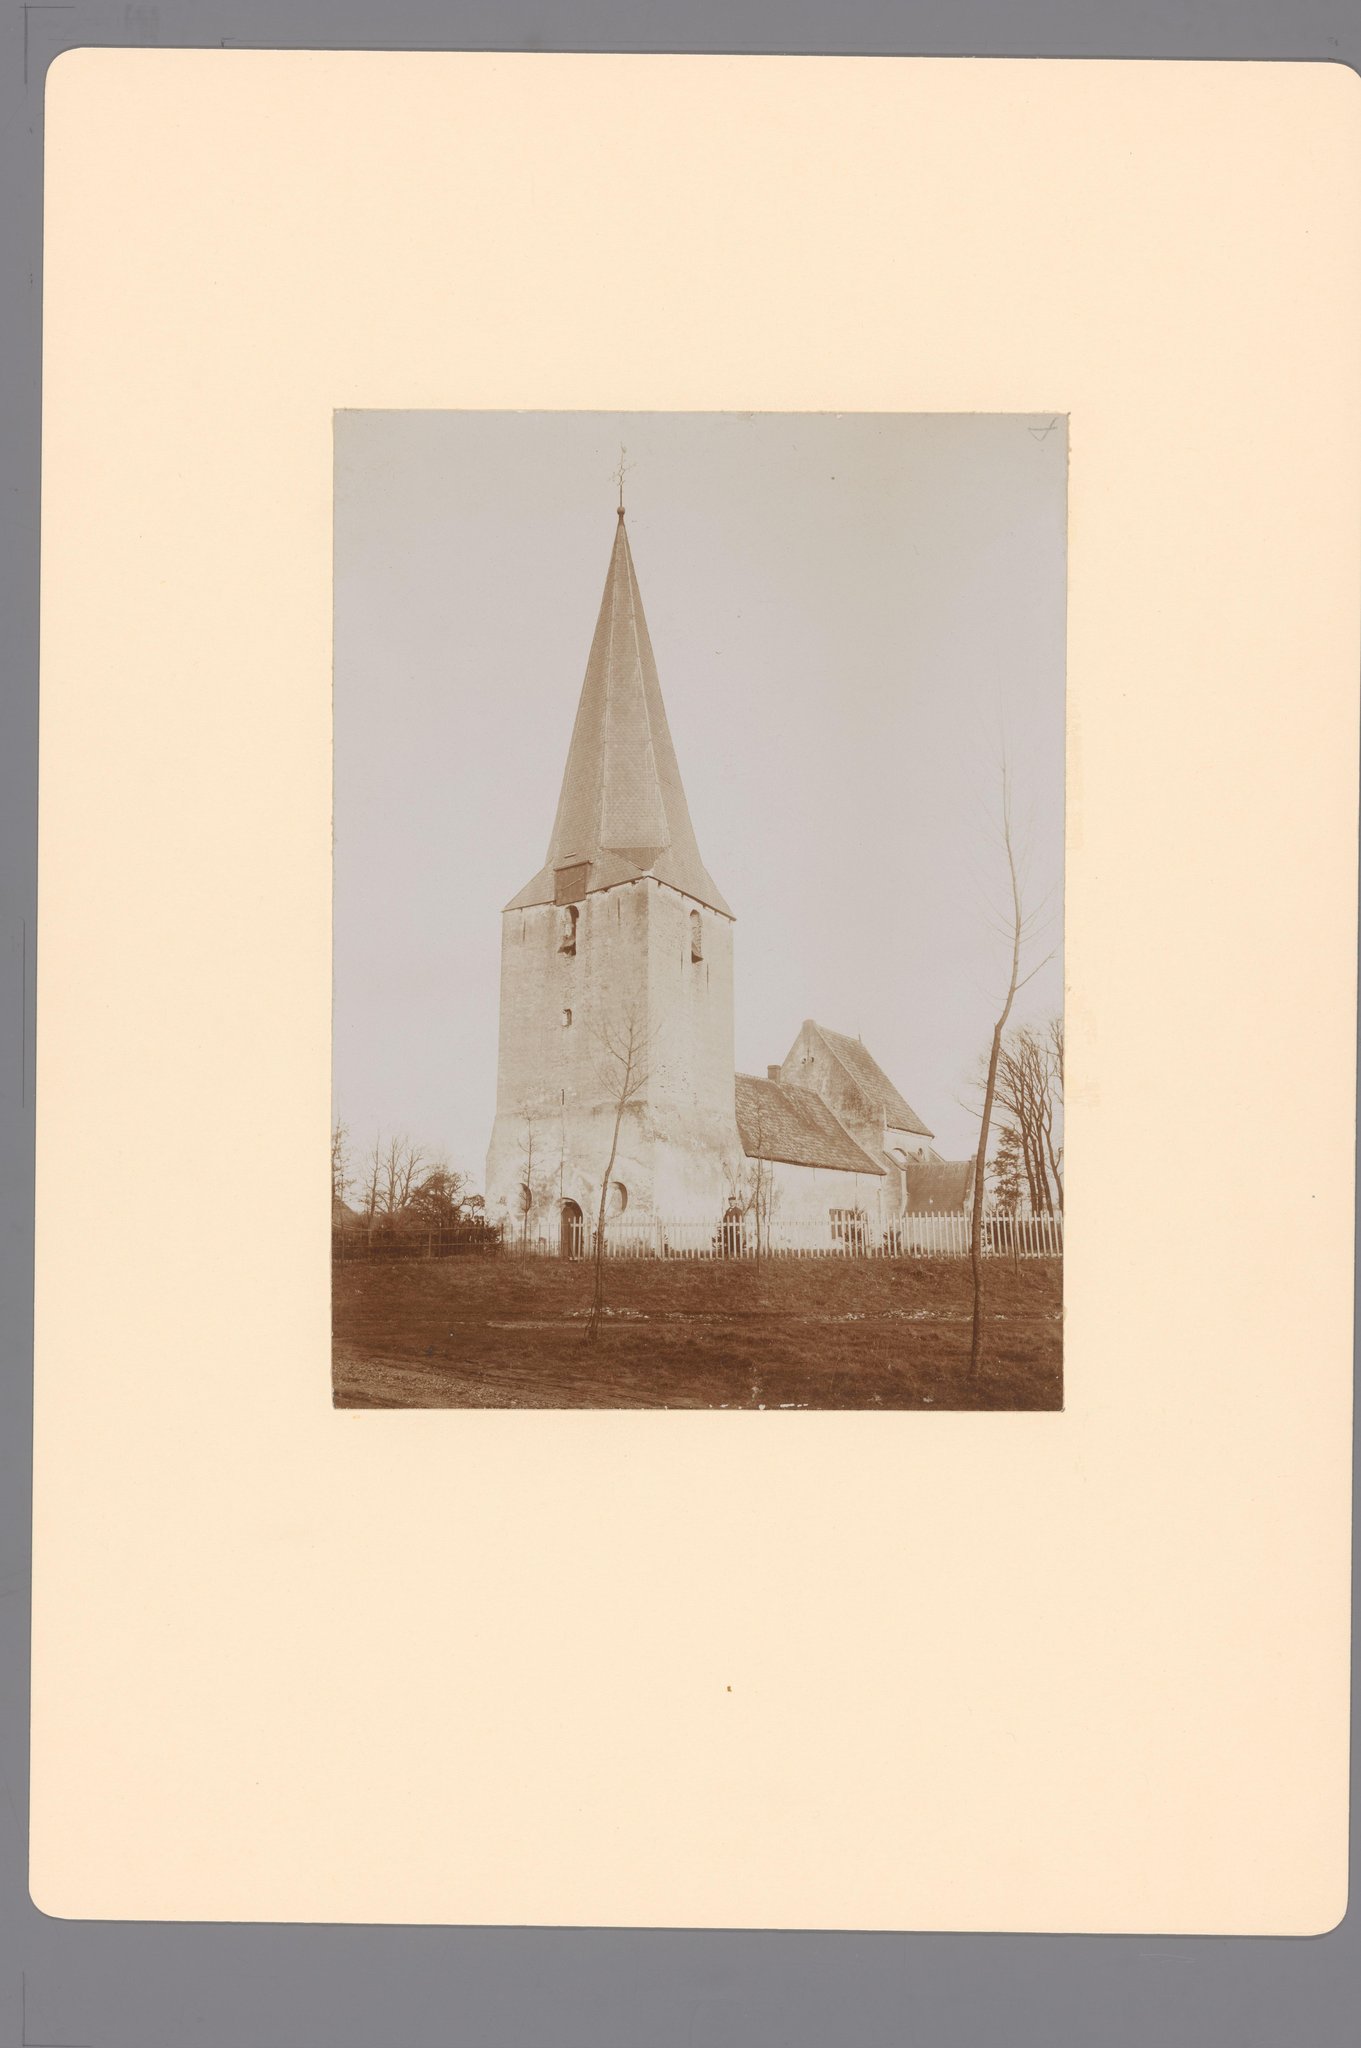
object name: photograph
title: Gezicht op de Hervormde kerk te Leur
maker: anoniem (monumentenzorg)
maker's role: fotograaf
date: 1890-1920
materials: cardboard, photographic support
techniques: collodion silver print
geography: leur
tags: church (exterior), landscapes in the temperate zone (+ landscape with figures, staffage)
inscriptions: annotation: ‘J’